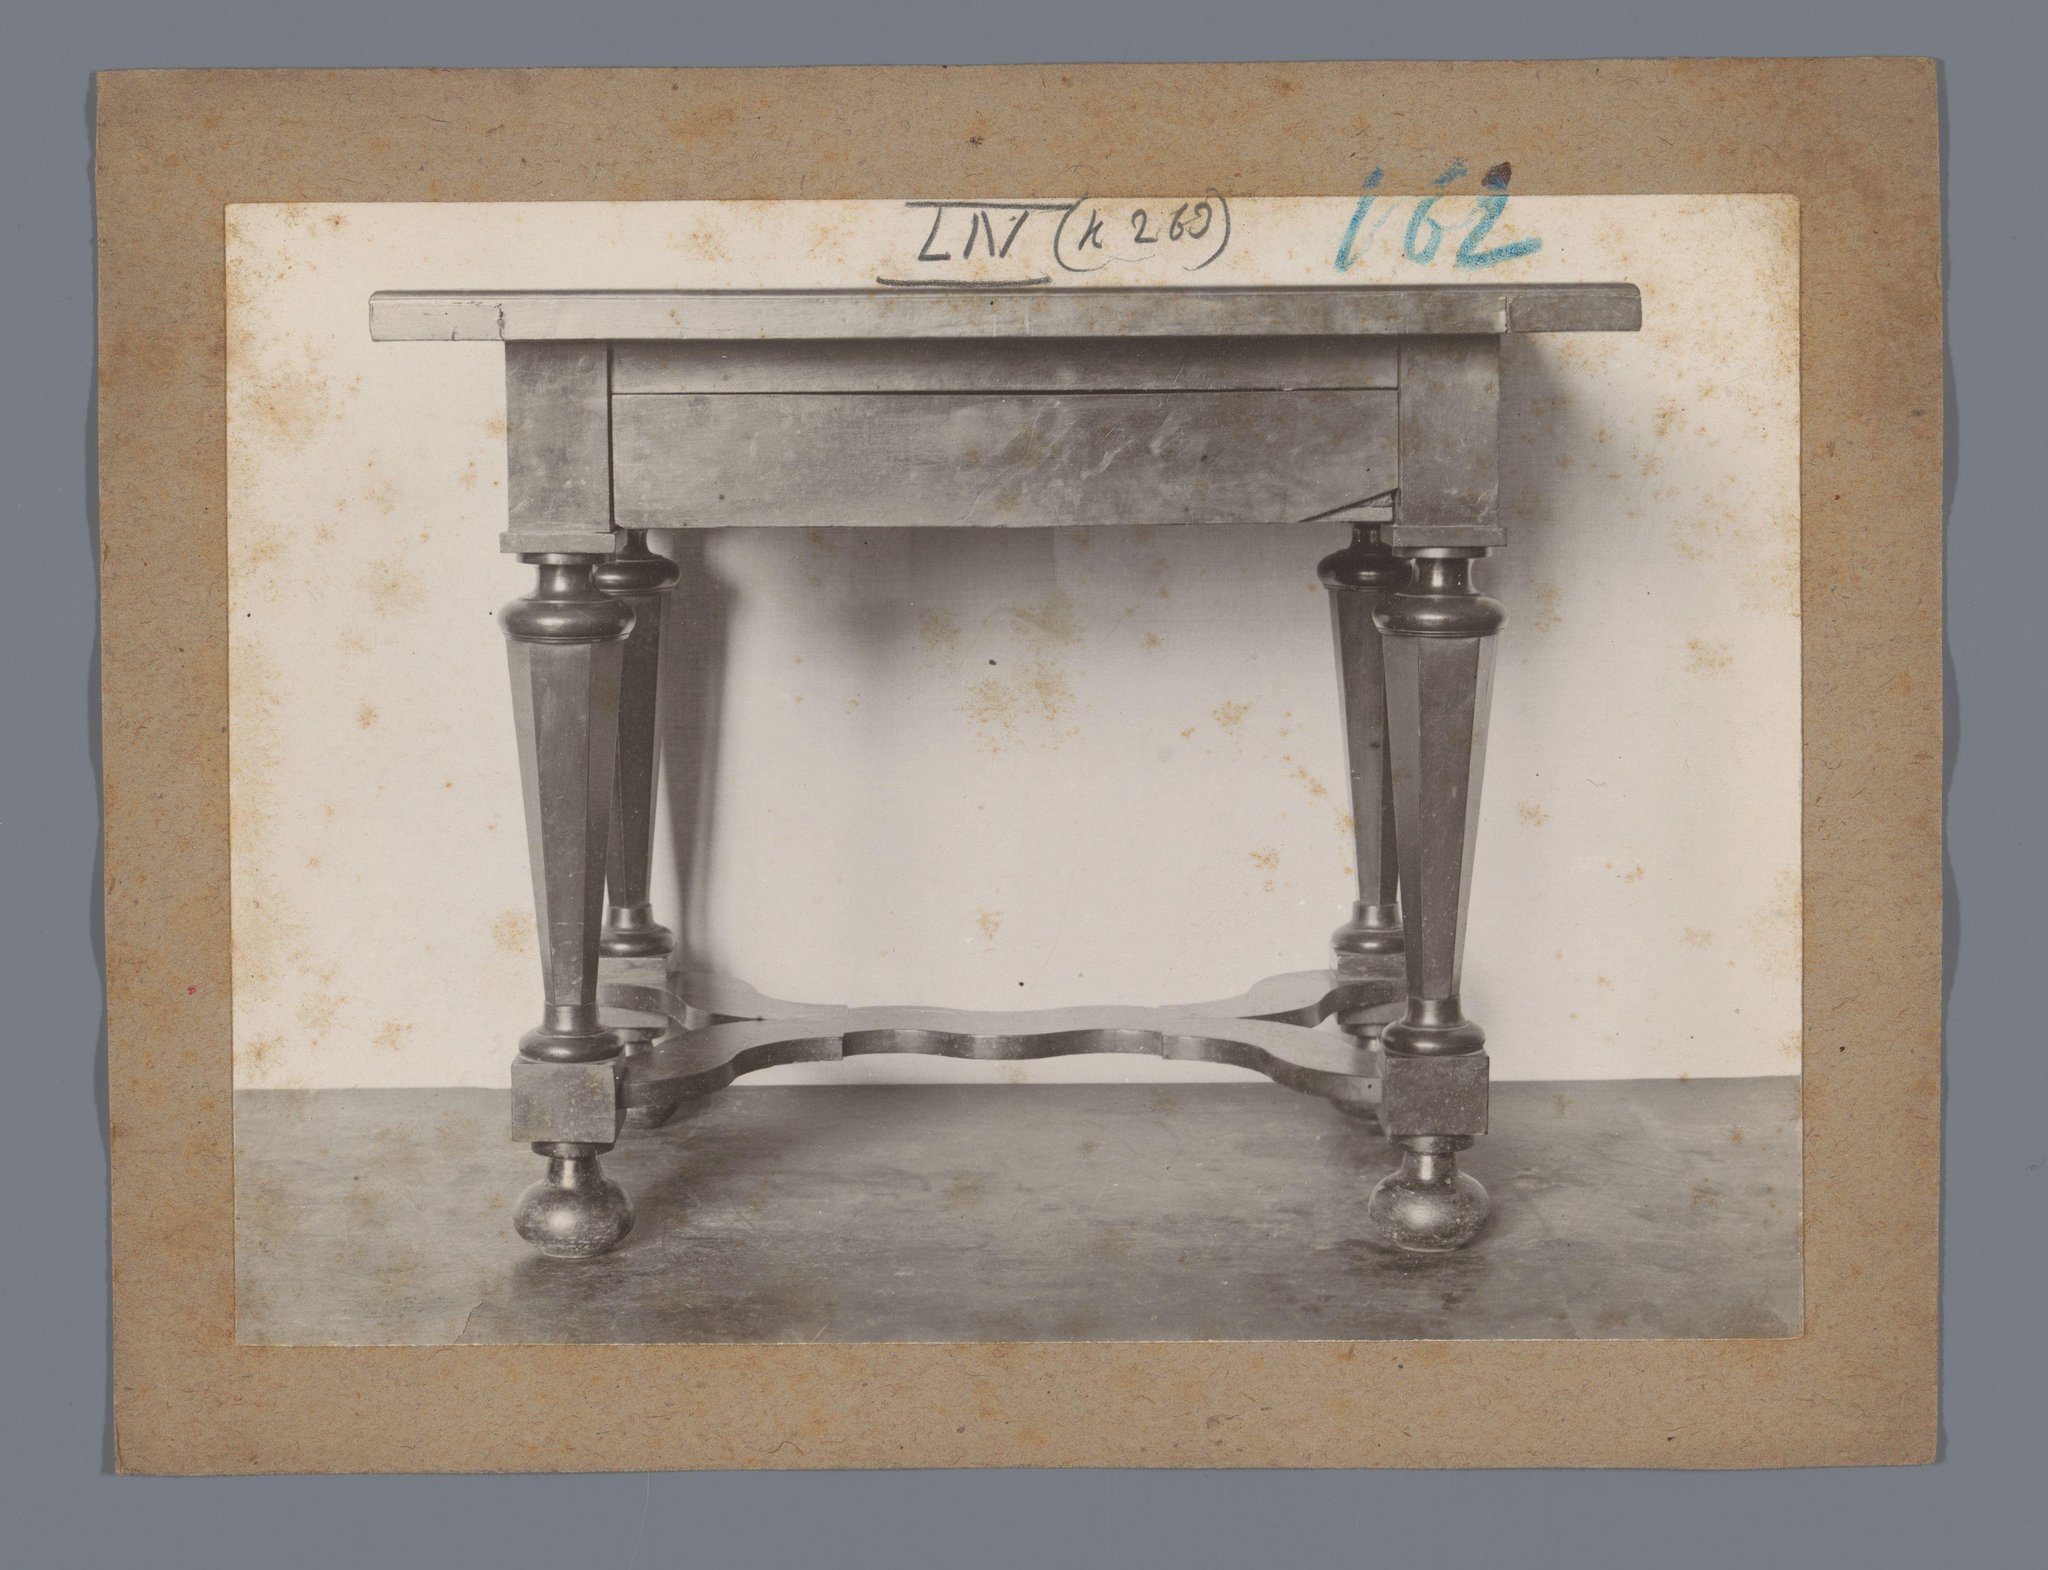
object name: photograph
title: Tafel met poten in de vorm van gestileerde zuilen verbonden door een dubbel Y-vormig kruis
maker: Anonymous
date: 1875-1900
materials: photographic support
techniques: matte daylight collodion silver print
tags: table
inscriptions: number: ‘LIV (K 263) 162’, collector's mark: ‘Instituut voor kunst-nijverheidsonderwijs Gabriël Metsustraat No. 16, Amsterdam’, collector's mark: ‘Kunstnijverheidschool Quellinus Amsterdam Frans Halsstraat 14.’